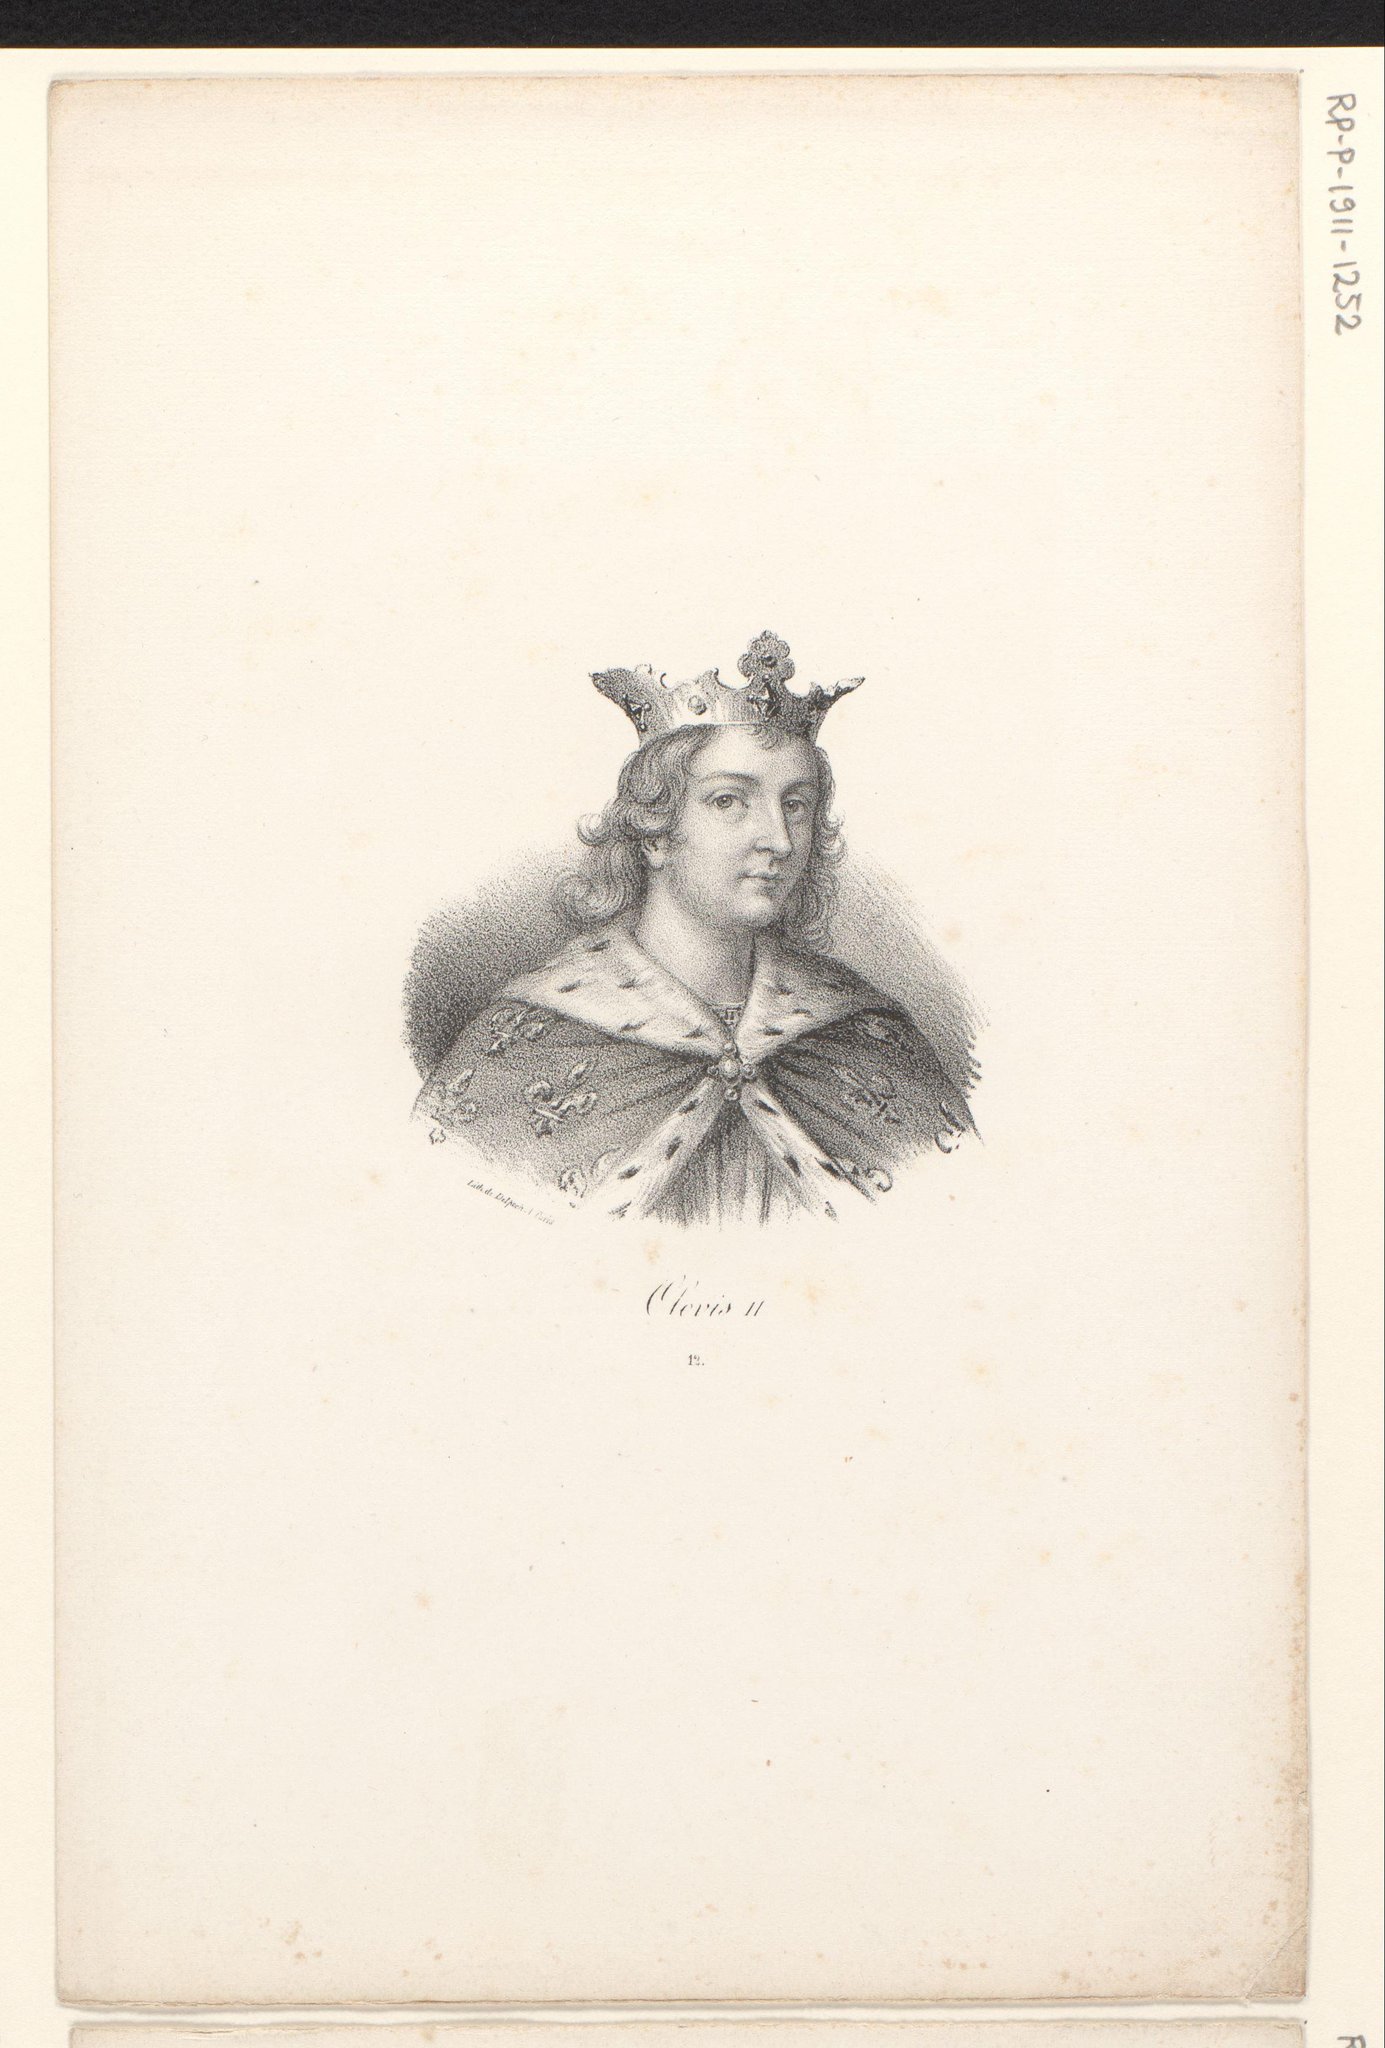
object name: print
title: Portret van Clovis II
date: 1818-1842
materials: paper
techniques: lithograph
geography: paris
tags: historical persons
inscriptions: collector's mark: Lugt 2228a